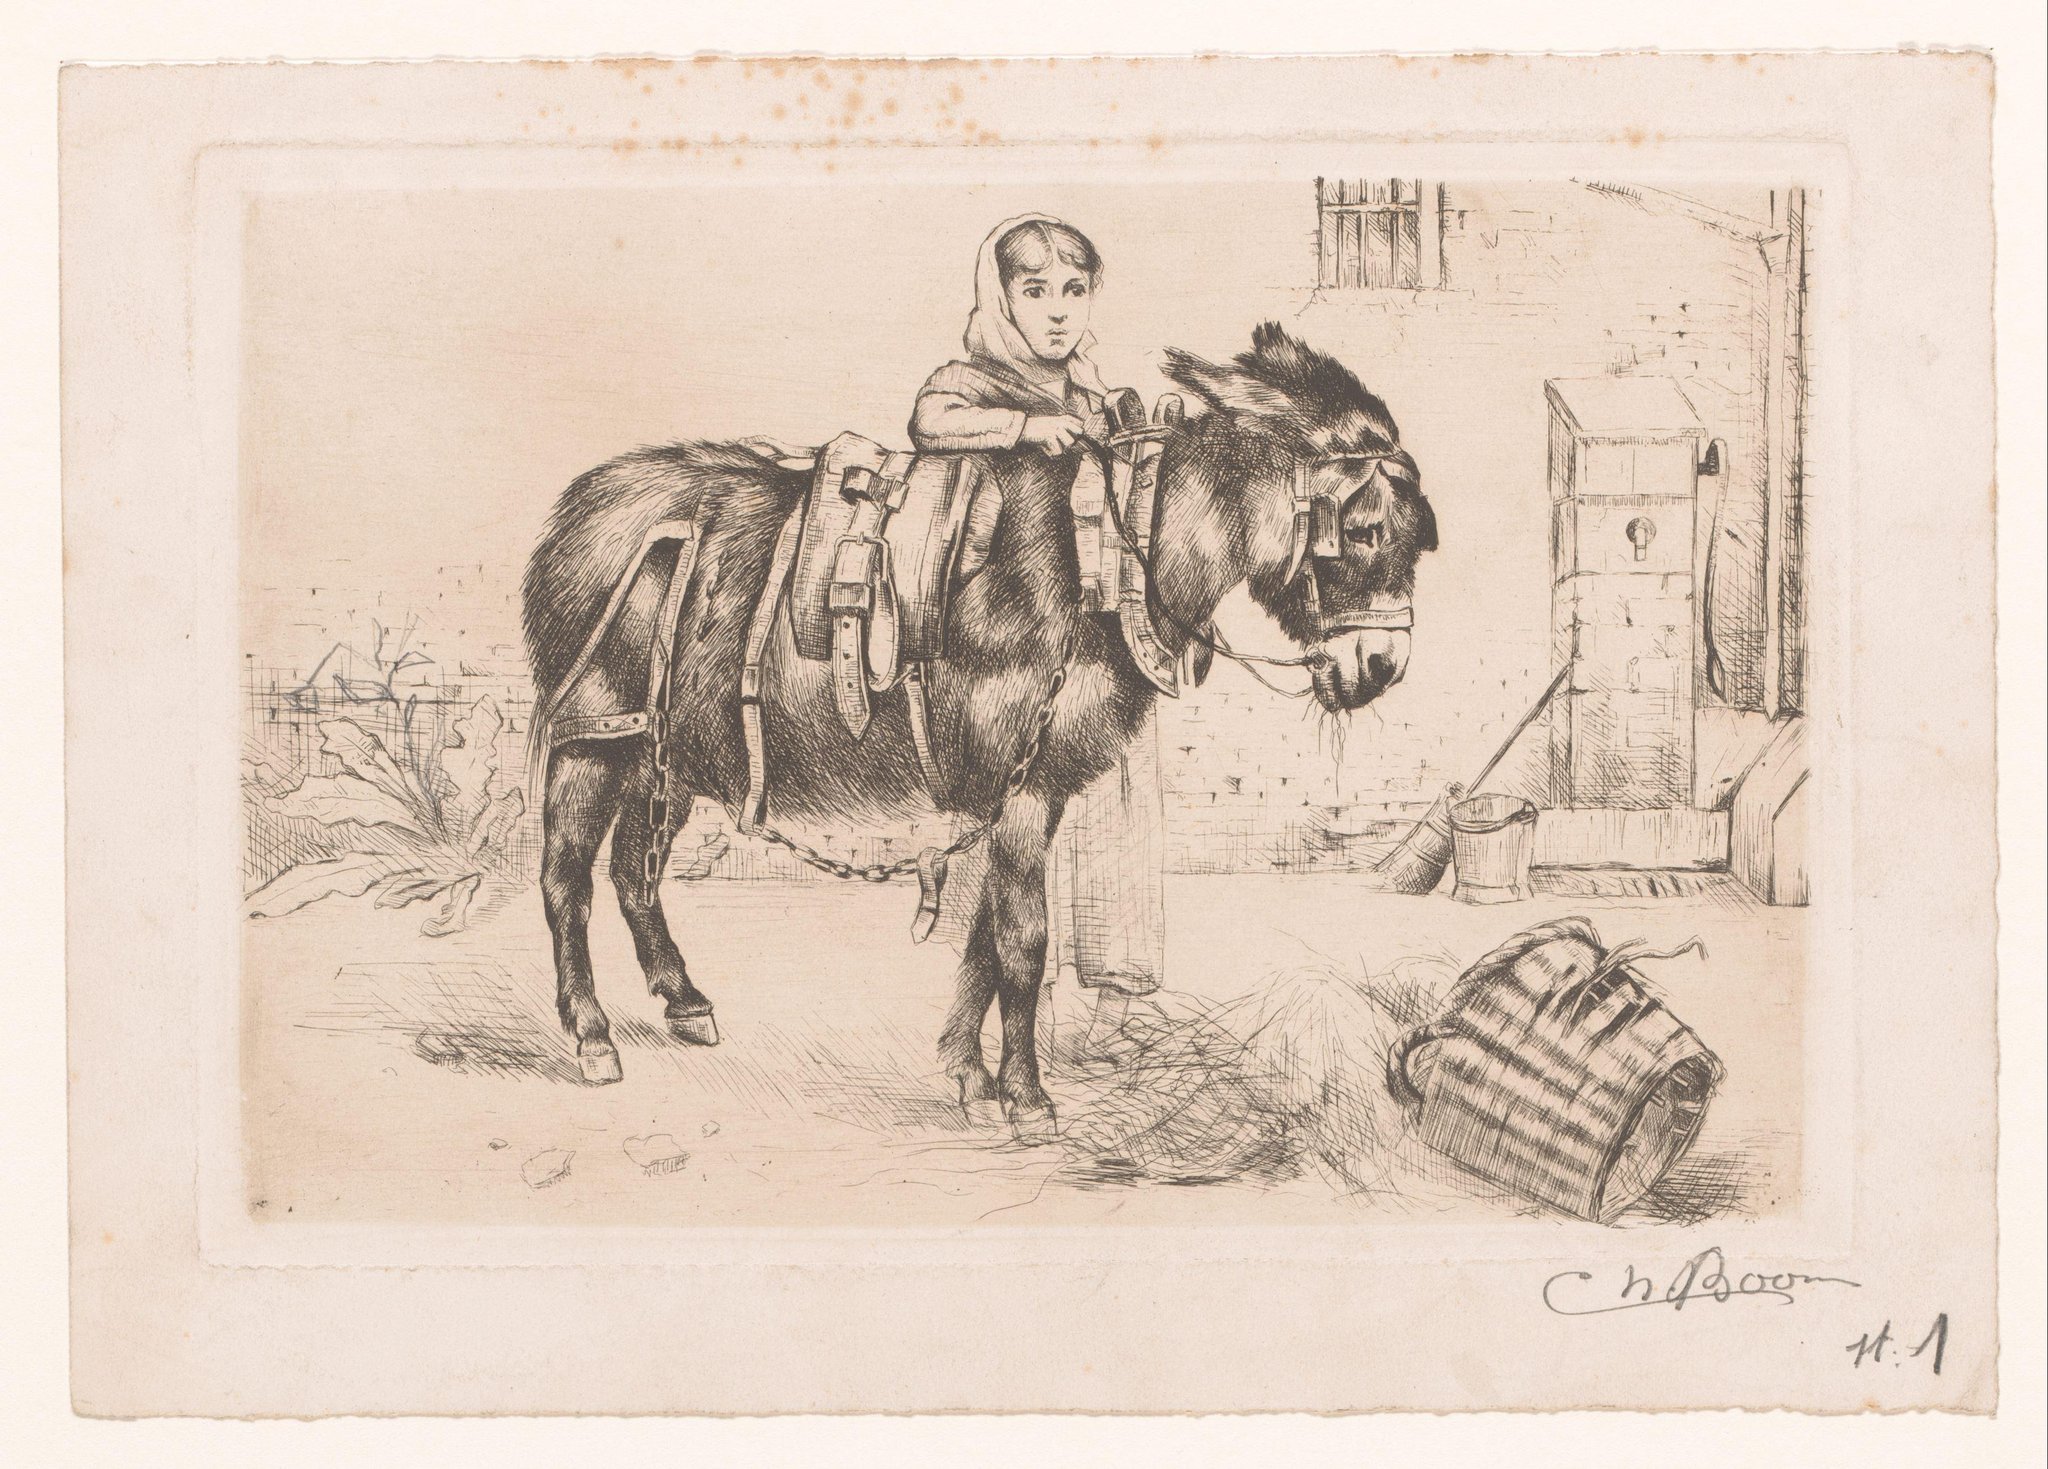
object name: print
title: Meisje met een ezel op een binnenplaats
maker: charles boom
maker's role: print maker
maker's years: 1858-1939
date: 1868-1909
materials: paper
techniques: etching, intaglio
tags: ass, donkey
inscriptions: annotation: ‘st. 1’, collector's mark: Lugt 2228